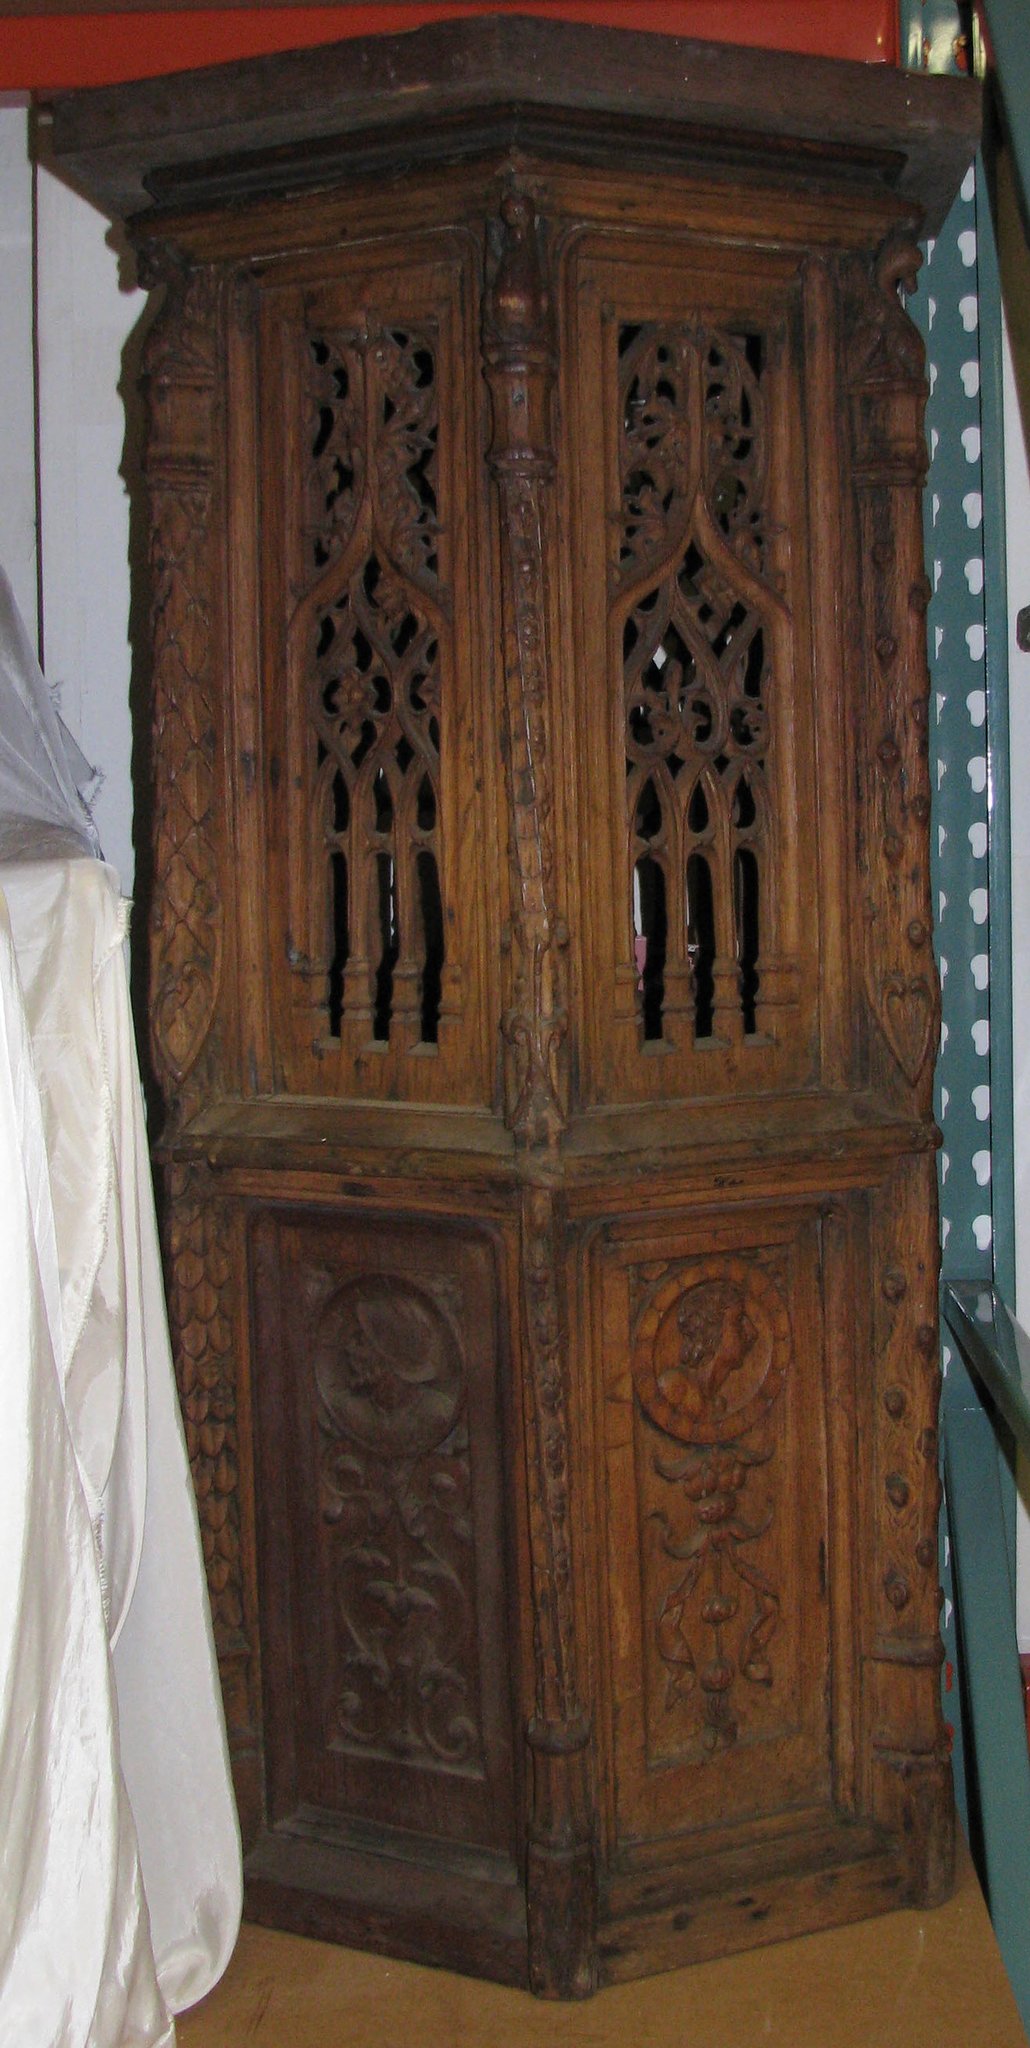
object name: cabinet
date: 1501-1533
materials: wood